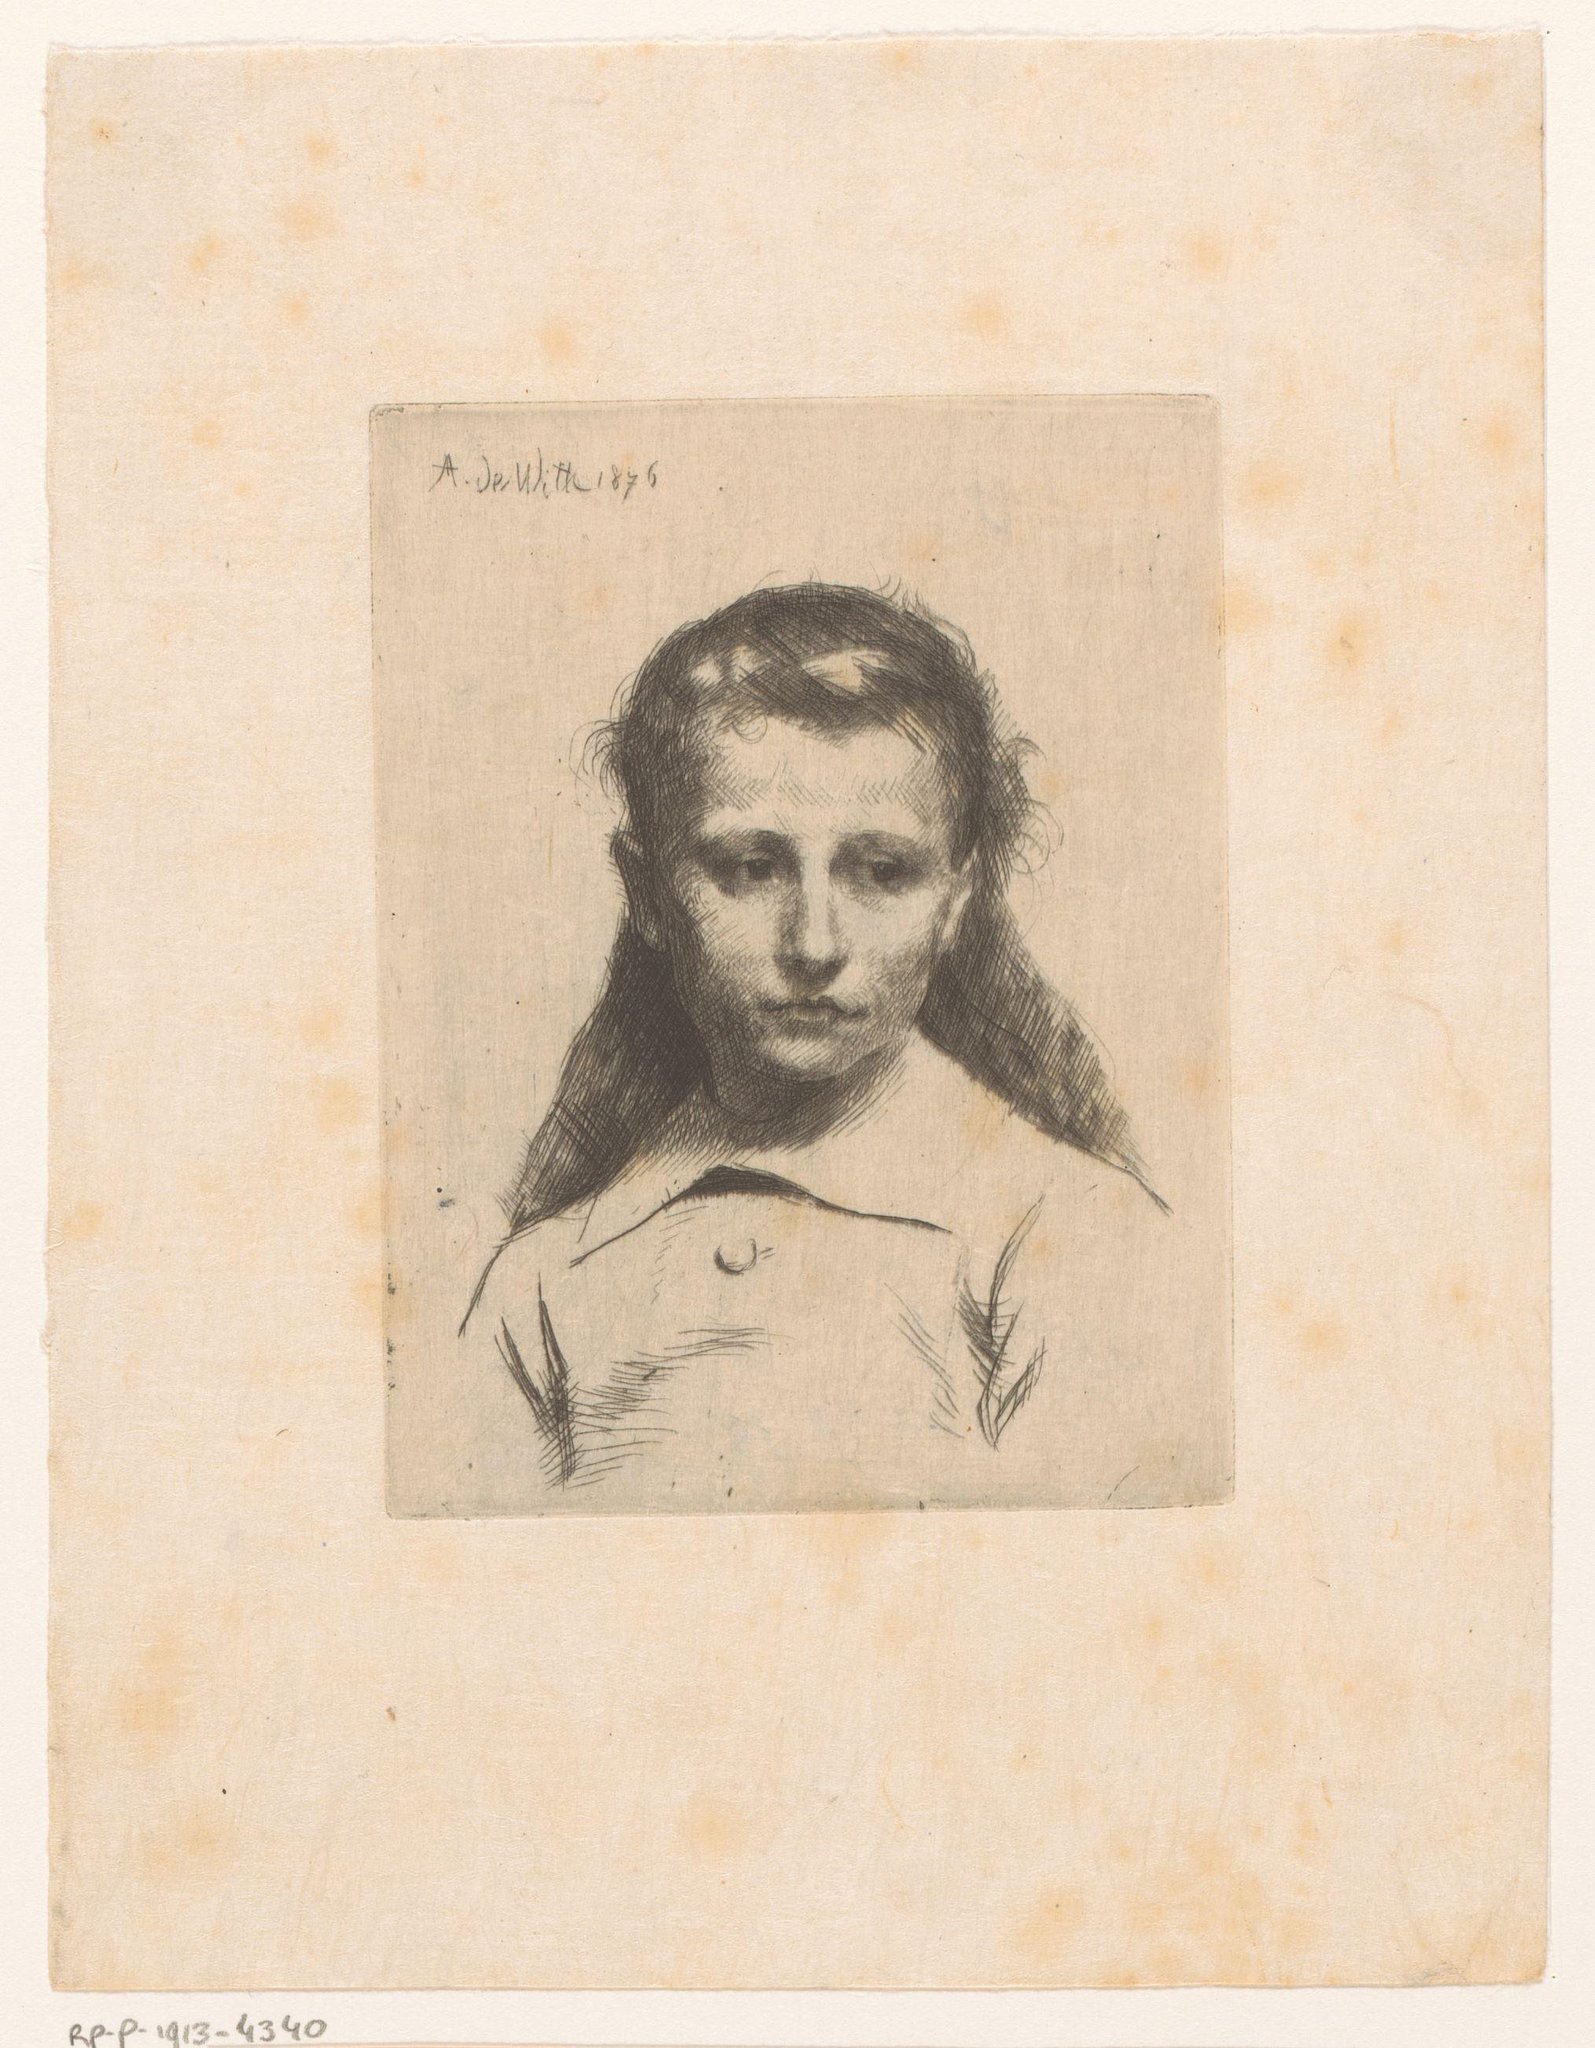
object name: print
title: Portret van Martine Zeyen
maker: adrien de witte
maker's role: print maker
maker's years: 1850-1935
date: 1876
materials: paper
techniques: drypoint, etching, retroussage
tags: adolescent, young woman, maiden, historical persons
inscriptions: collector's mark: Lugt 2228